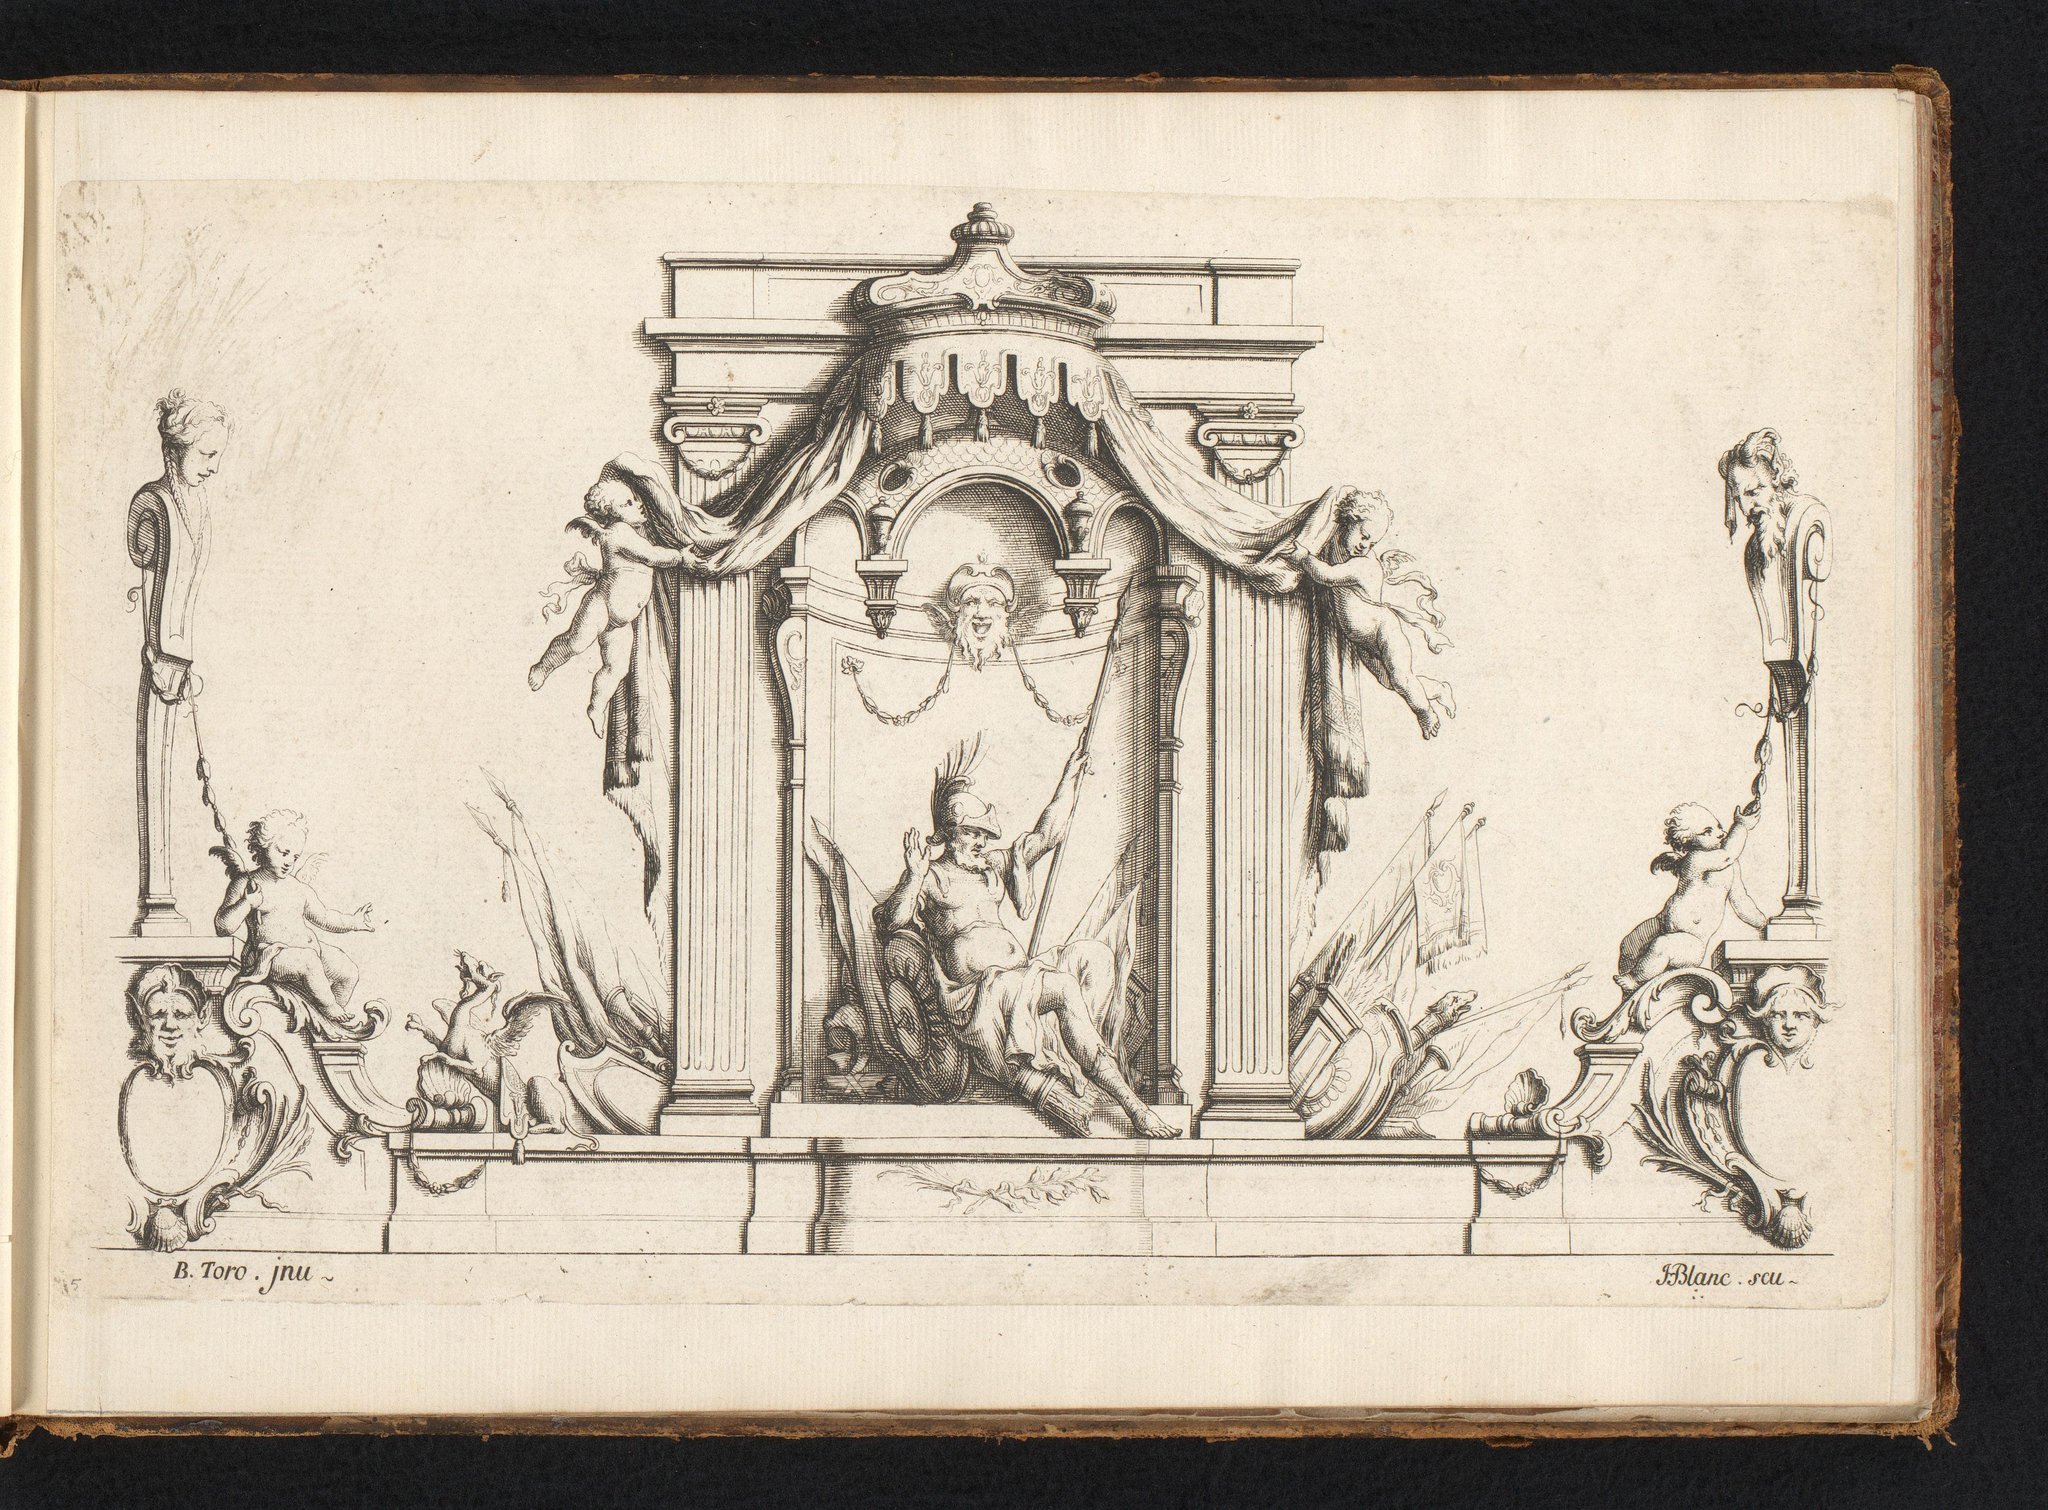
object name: ornament print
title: Mars zittend onder een baldakijn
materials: paper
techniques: etching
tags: (story of) mars (ares), 'tropaion', i.e. decorative ornament ~ weapons, weapons, other hybrid forms in the shape of a pillar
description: Prent maakt deel uit van een serie van zes prenten.